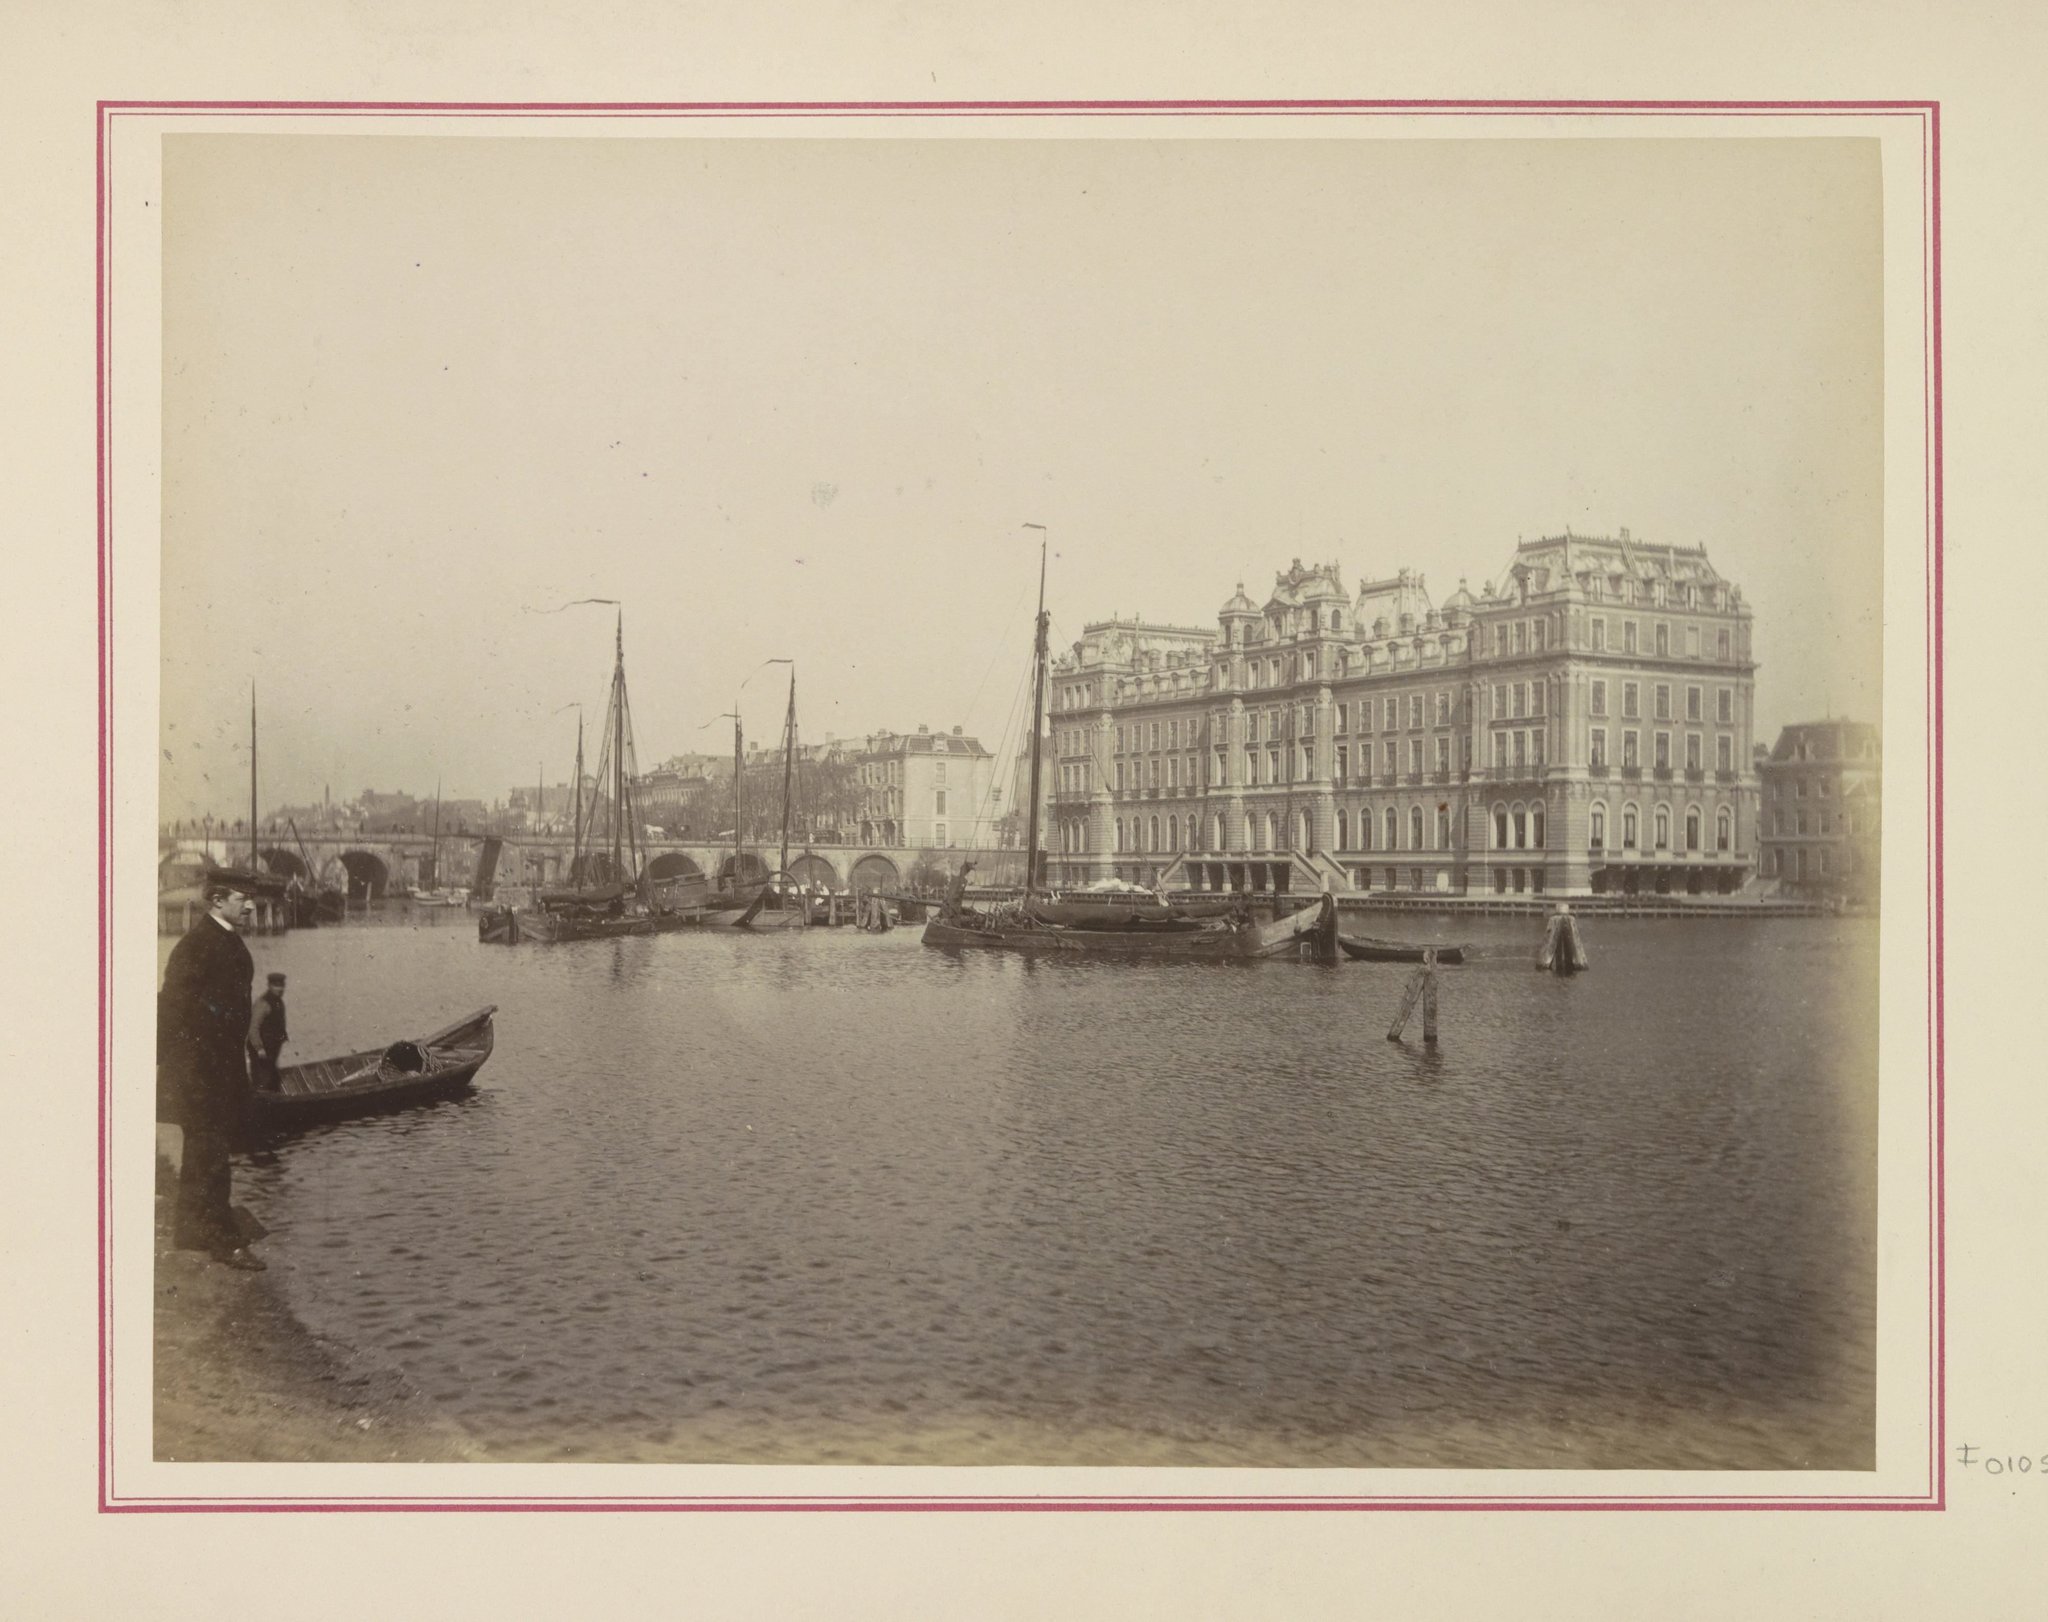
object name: photograph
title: Amstel Hotel in Amsterdam gezien vanuit zuidwest over de Amstel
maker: Anonymous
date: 1890-1900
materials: photographic support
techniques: albumen print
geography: amsterdam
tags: river, bridge in city across river, canal, etc., hotel, hostelry, inn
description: Onderdeel van Fotoalbum met opnames van bezienswaardigheden in Amsterdam.